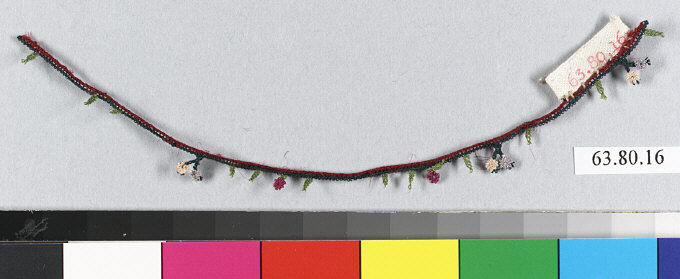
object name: piece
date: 1801-1900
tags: flowers